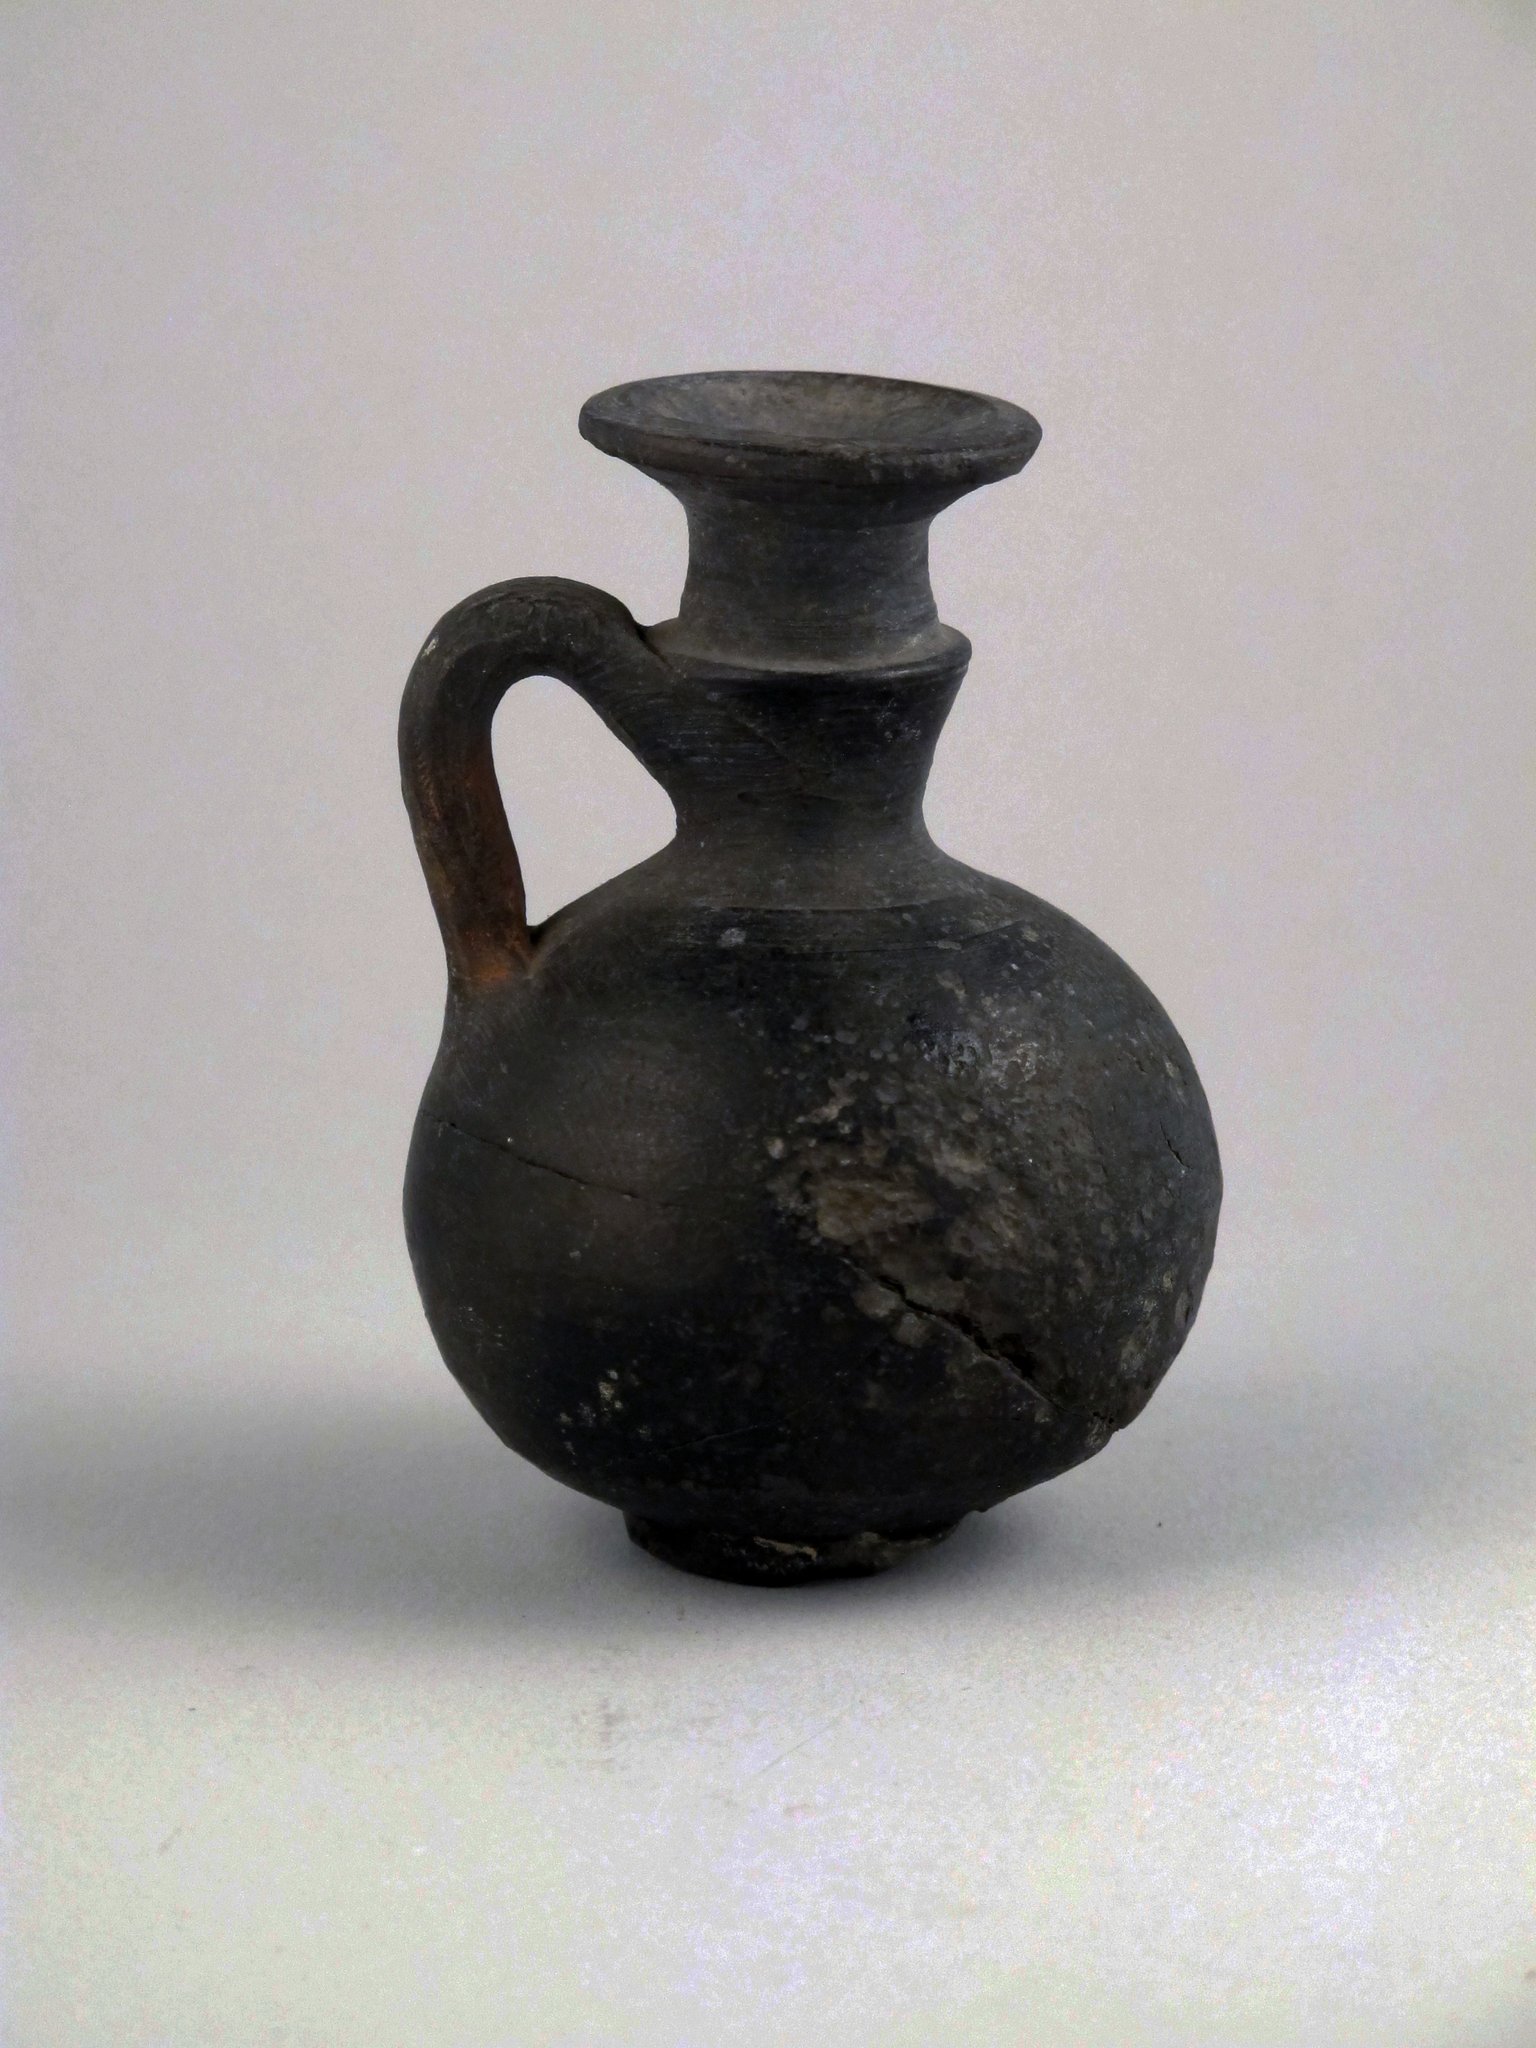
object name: juglet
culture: cypriot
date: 750-600 BCE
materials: terracotta